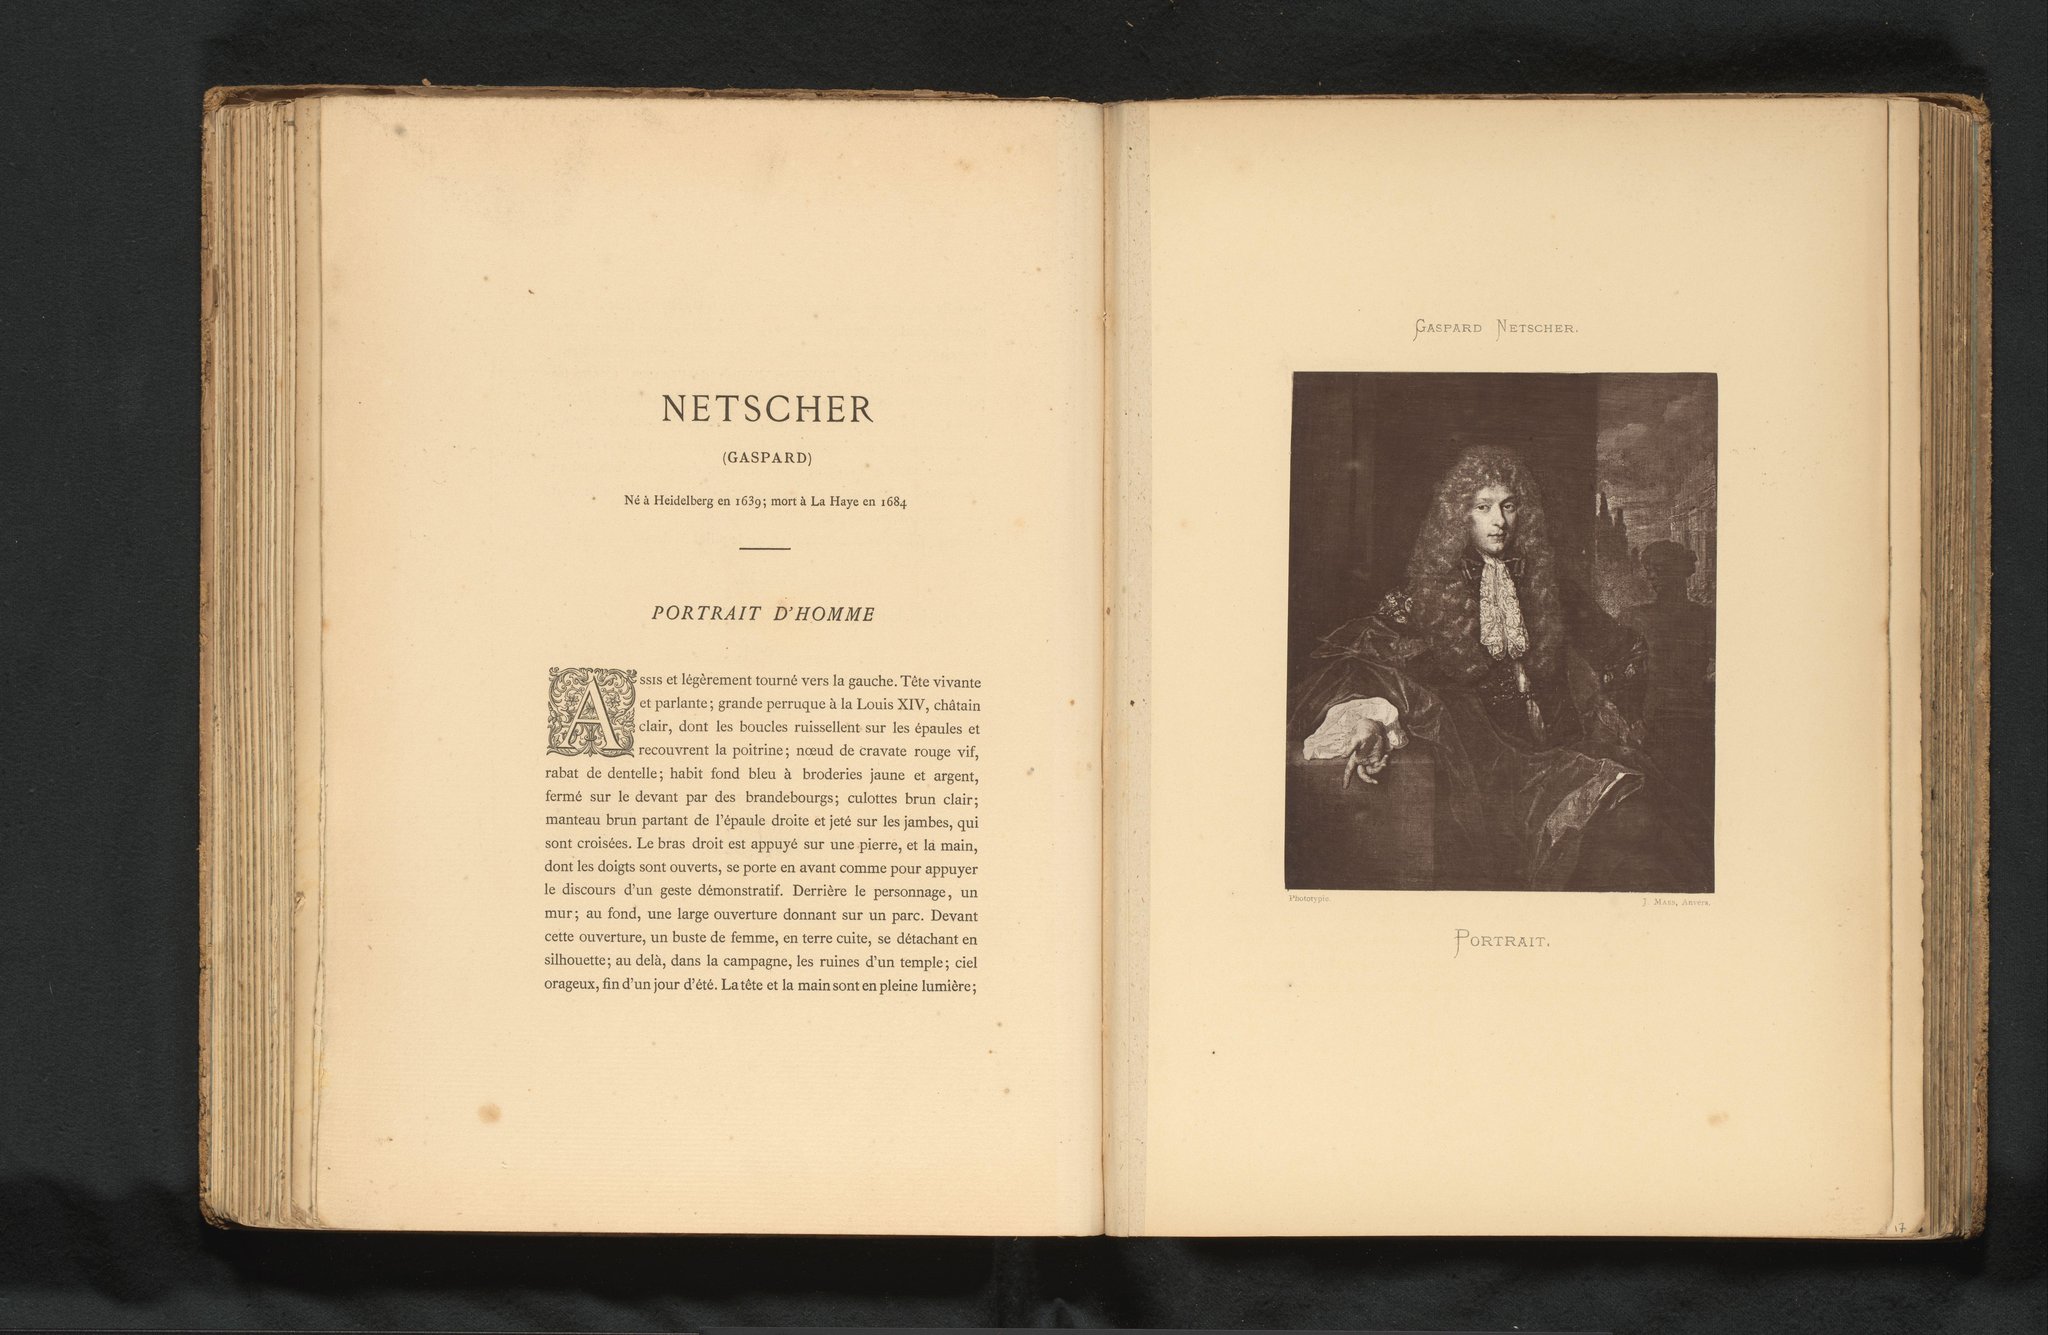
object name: page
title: Portrait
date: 1873-1878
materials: paper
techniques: woodburytype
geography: antwerp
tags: historical persons